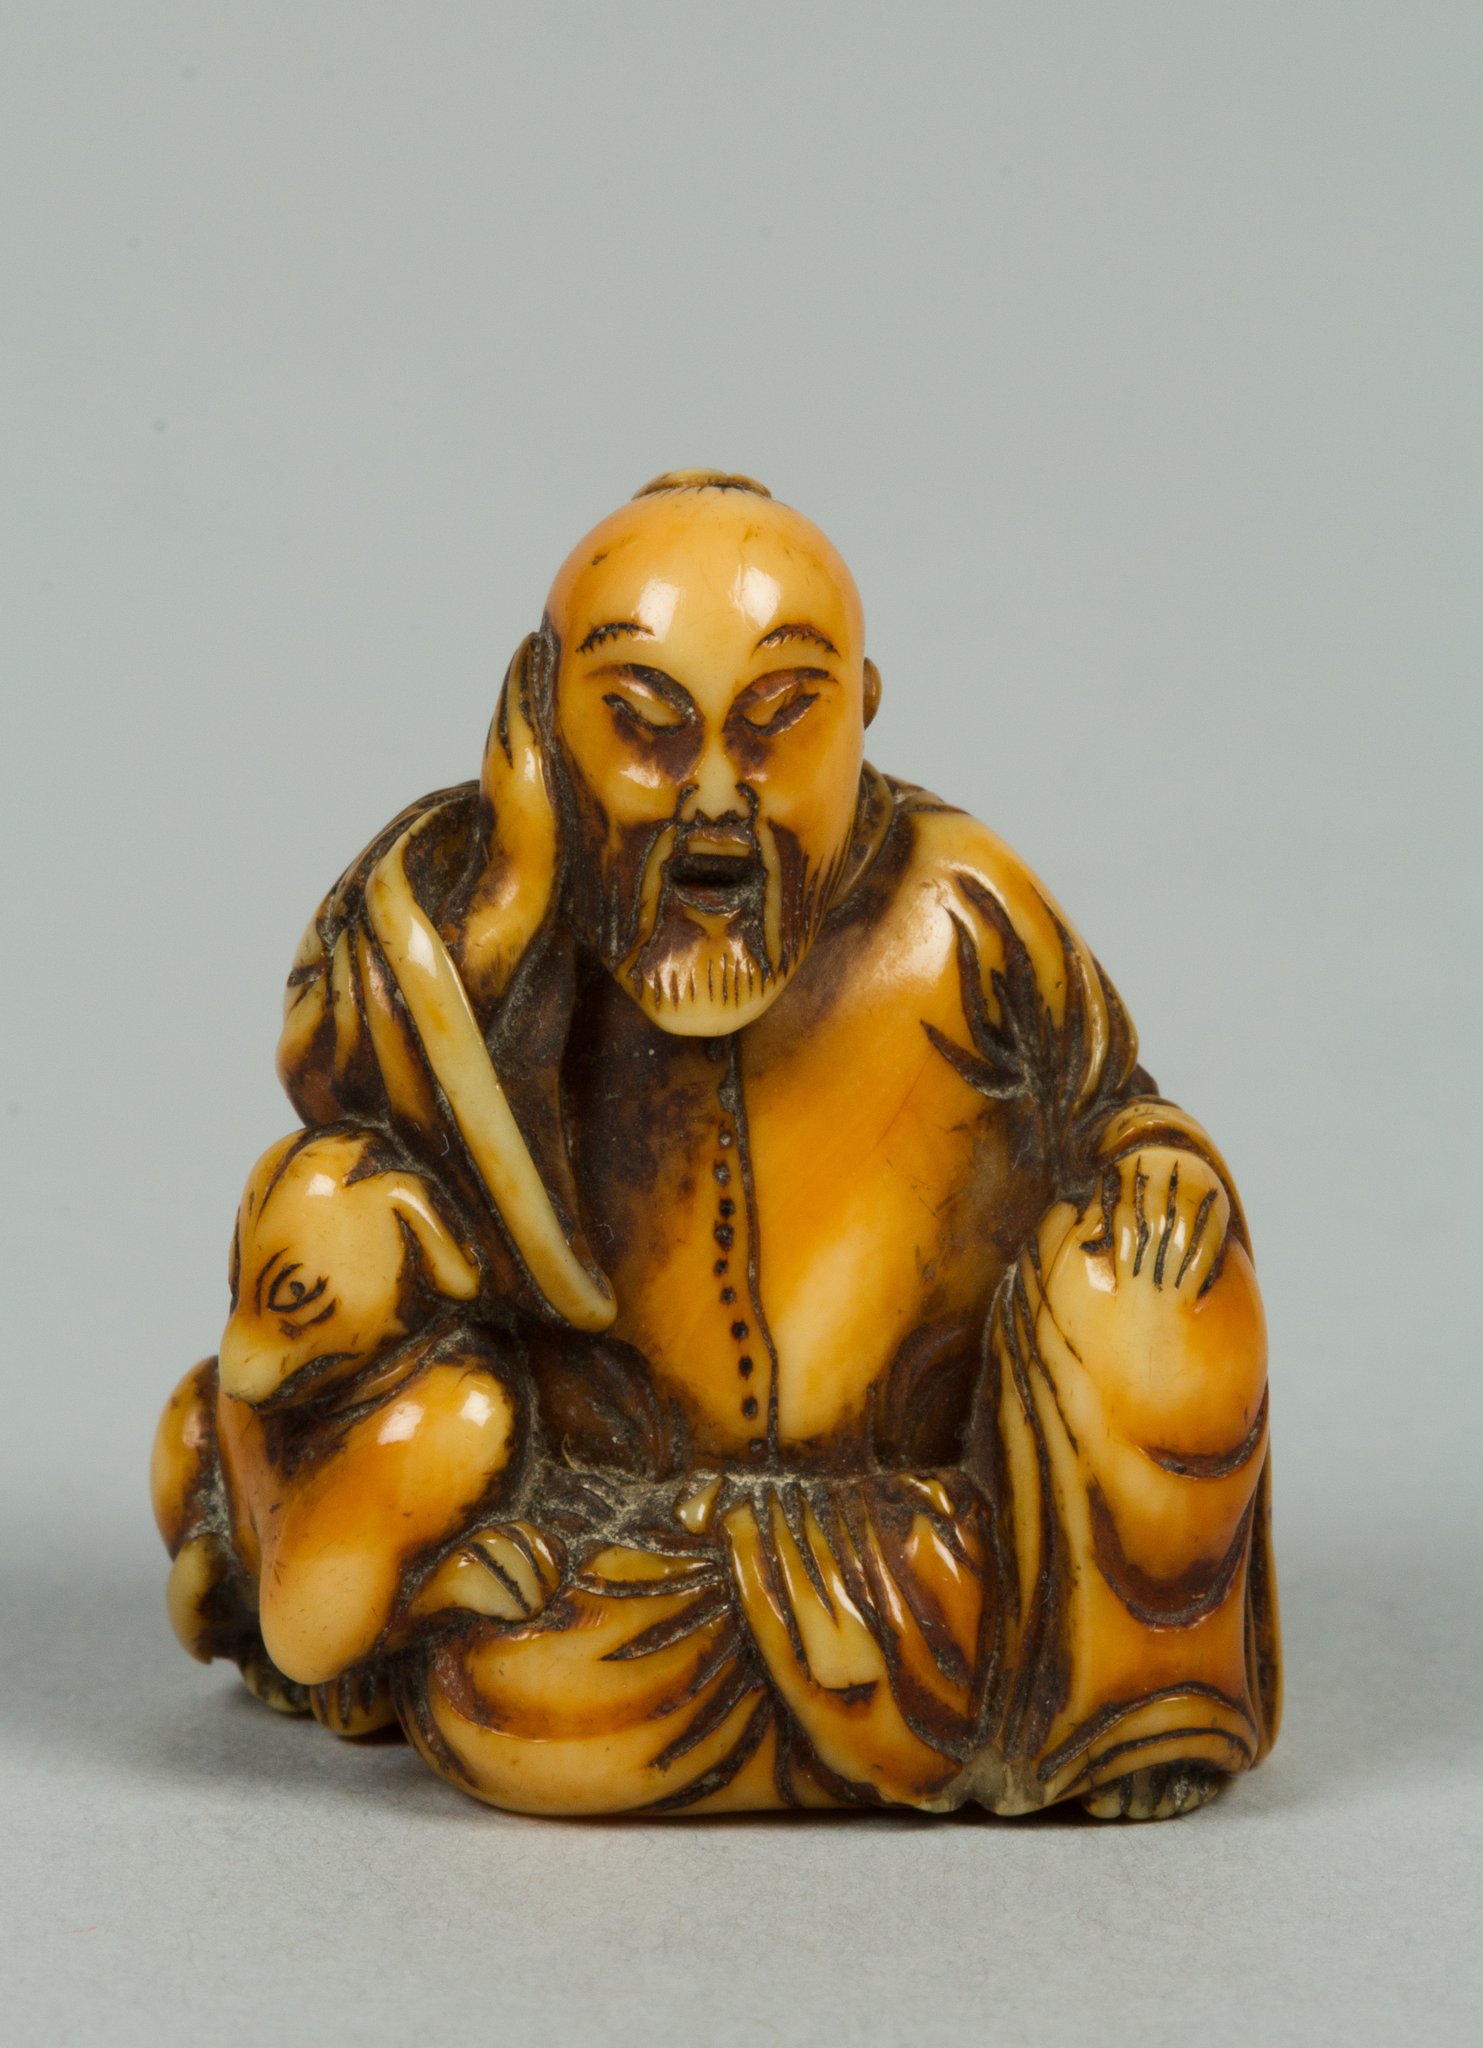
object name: netsuke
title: Netsuke of Seated Figure of Old Man with a Dog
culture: japanese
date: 1801-1900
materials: ivory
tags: men,dogs